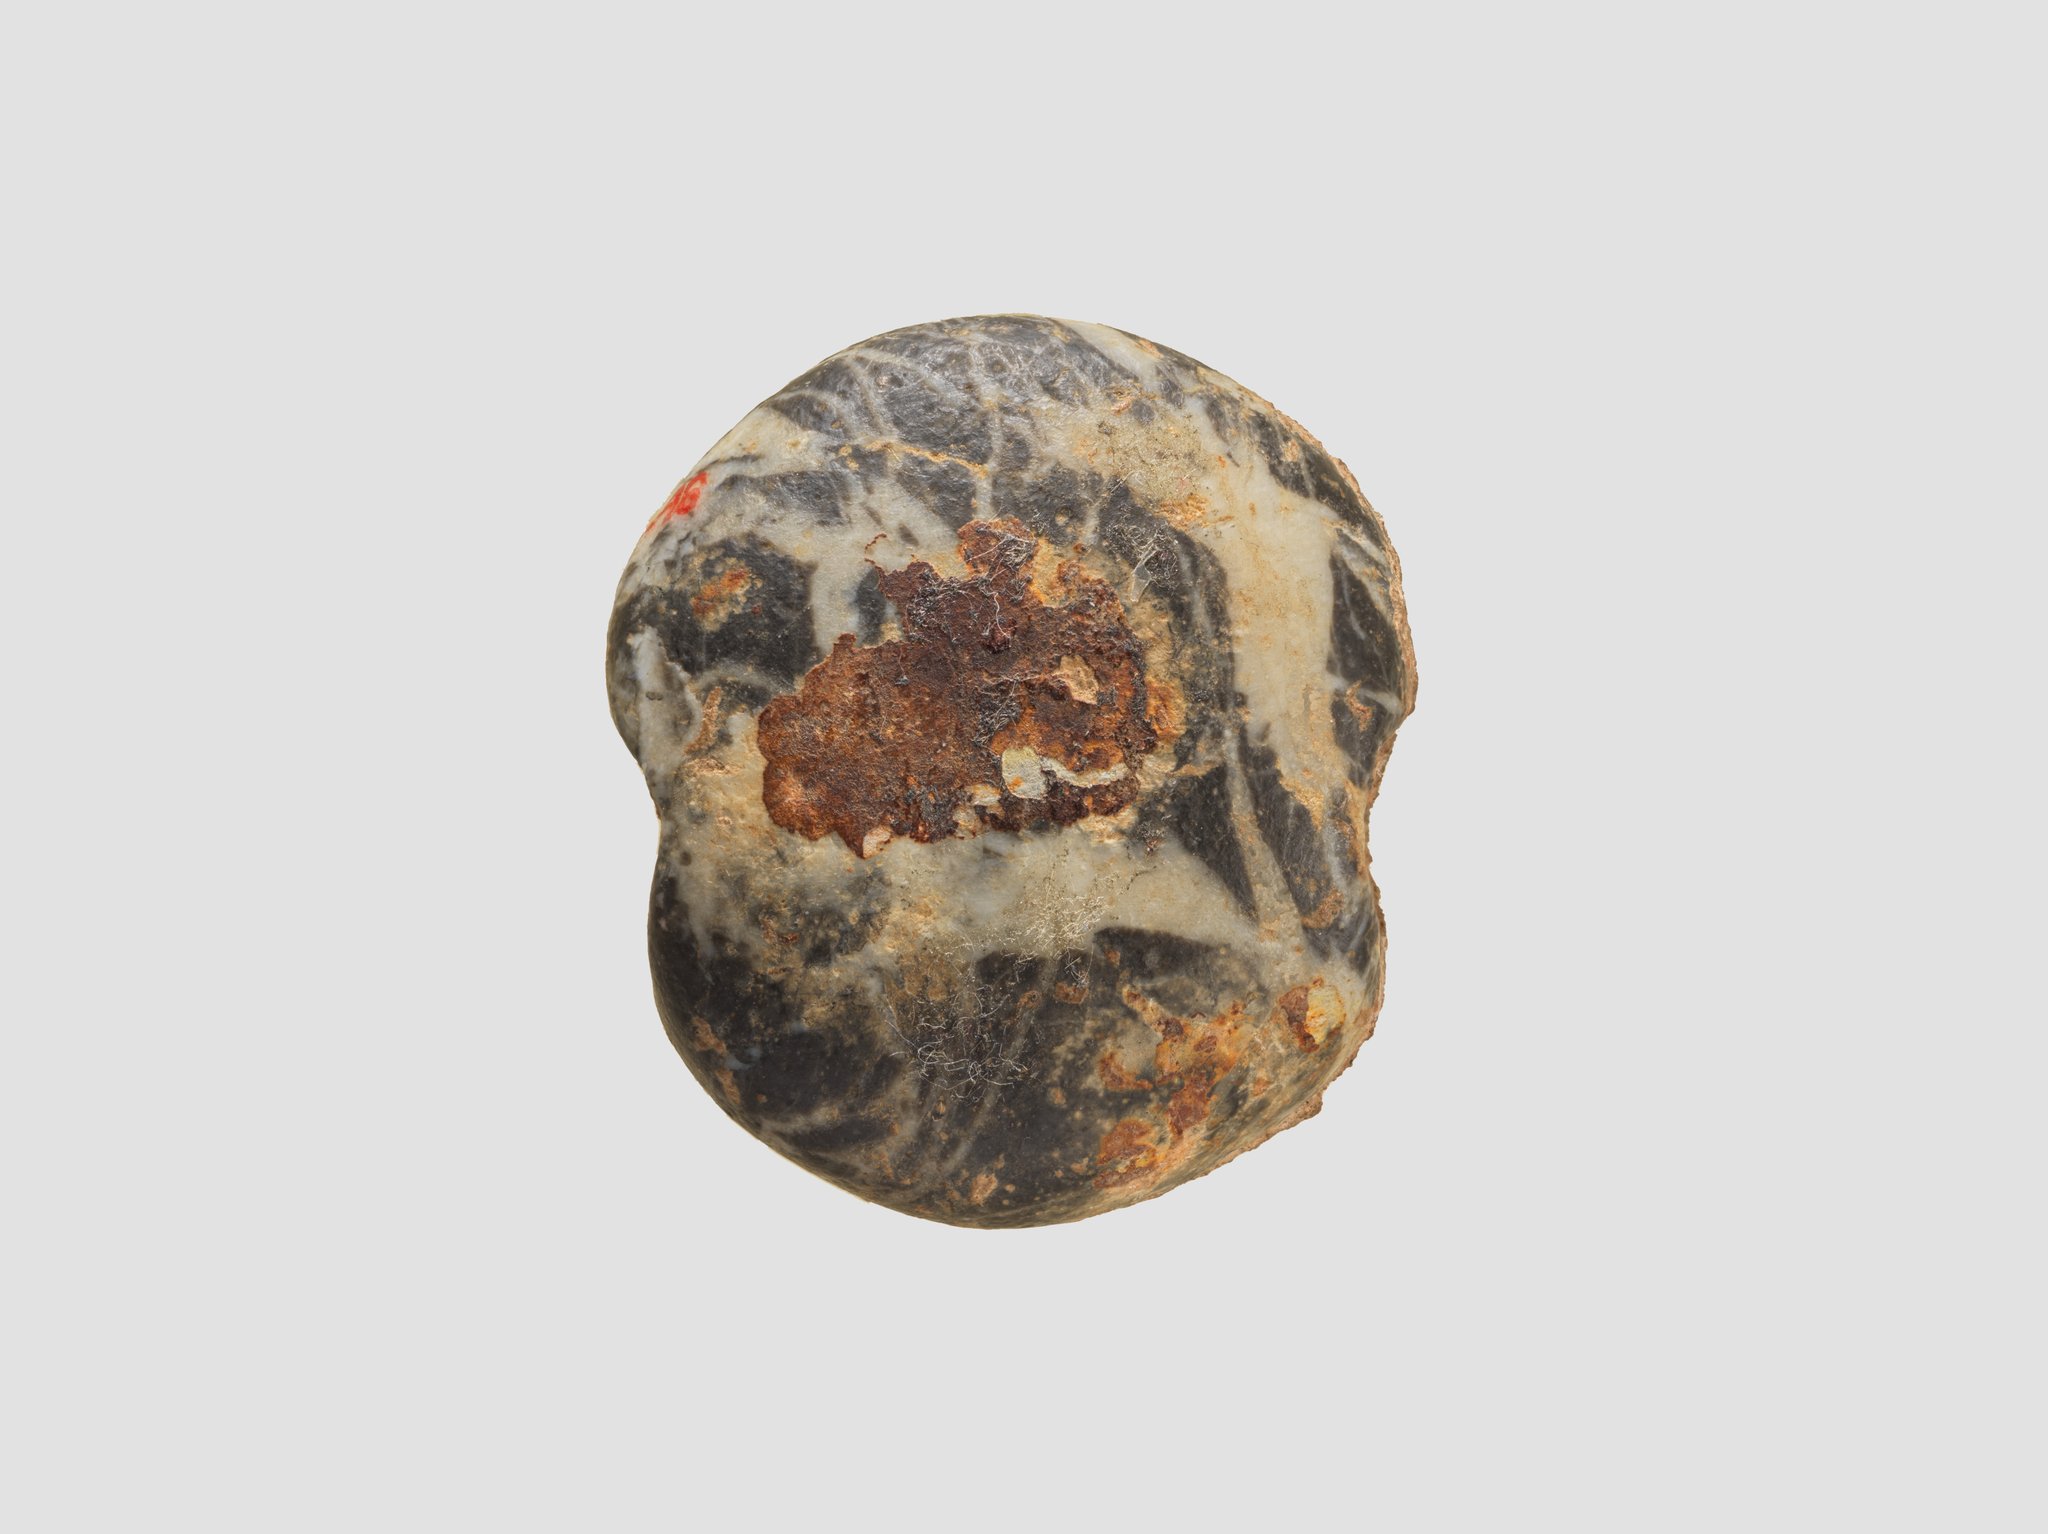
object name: bead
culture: iranian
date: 800-601 BCE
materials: stone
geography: iran, luristan